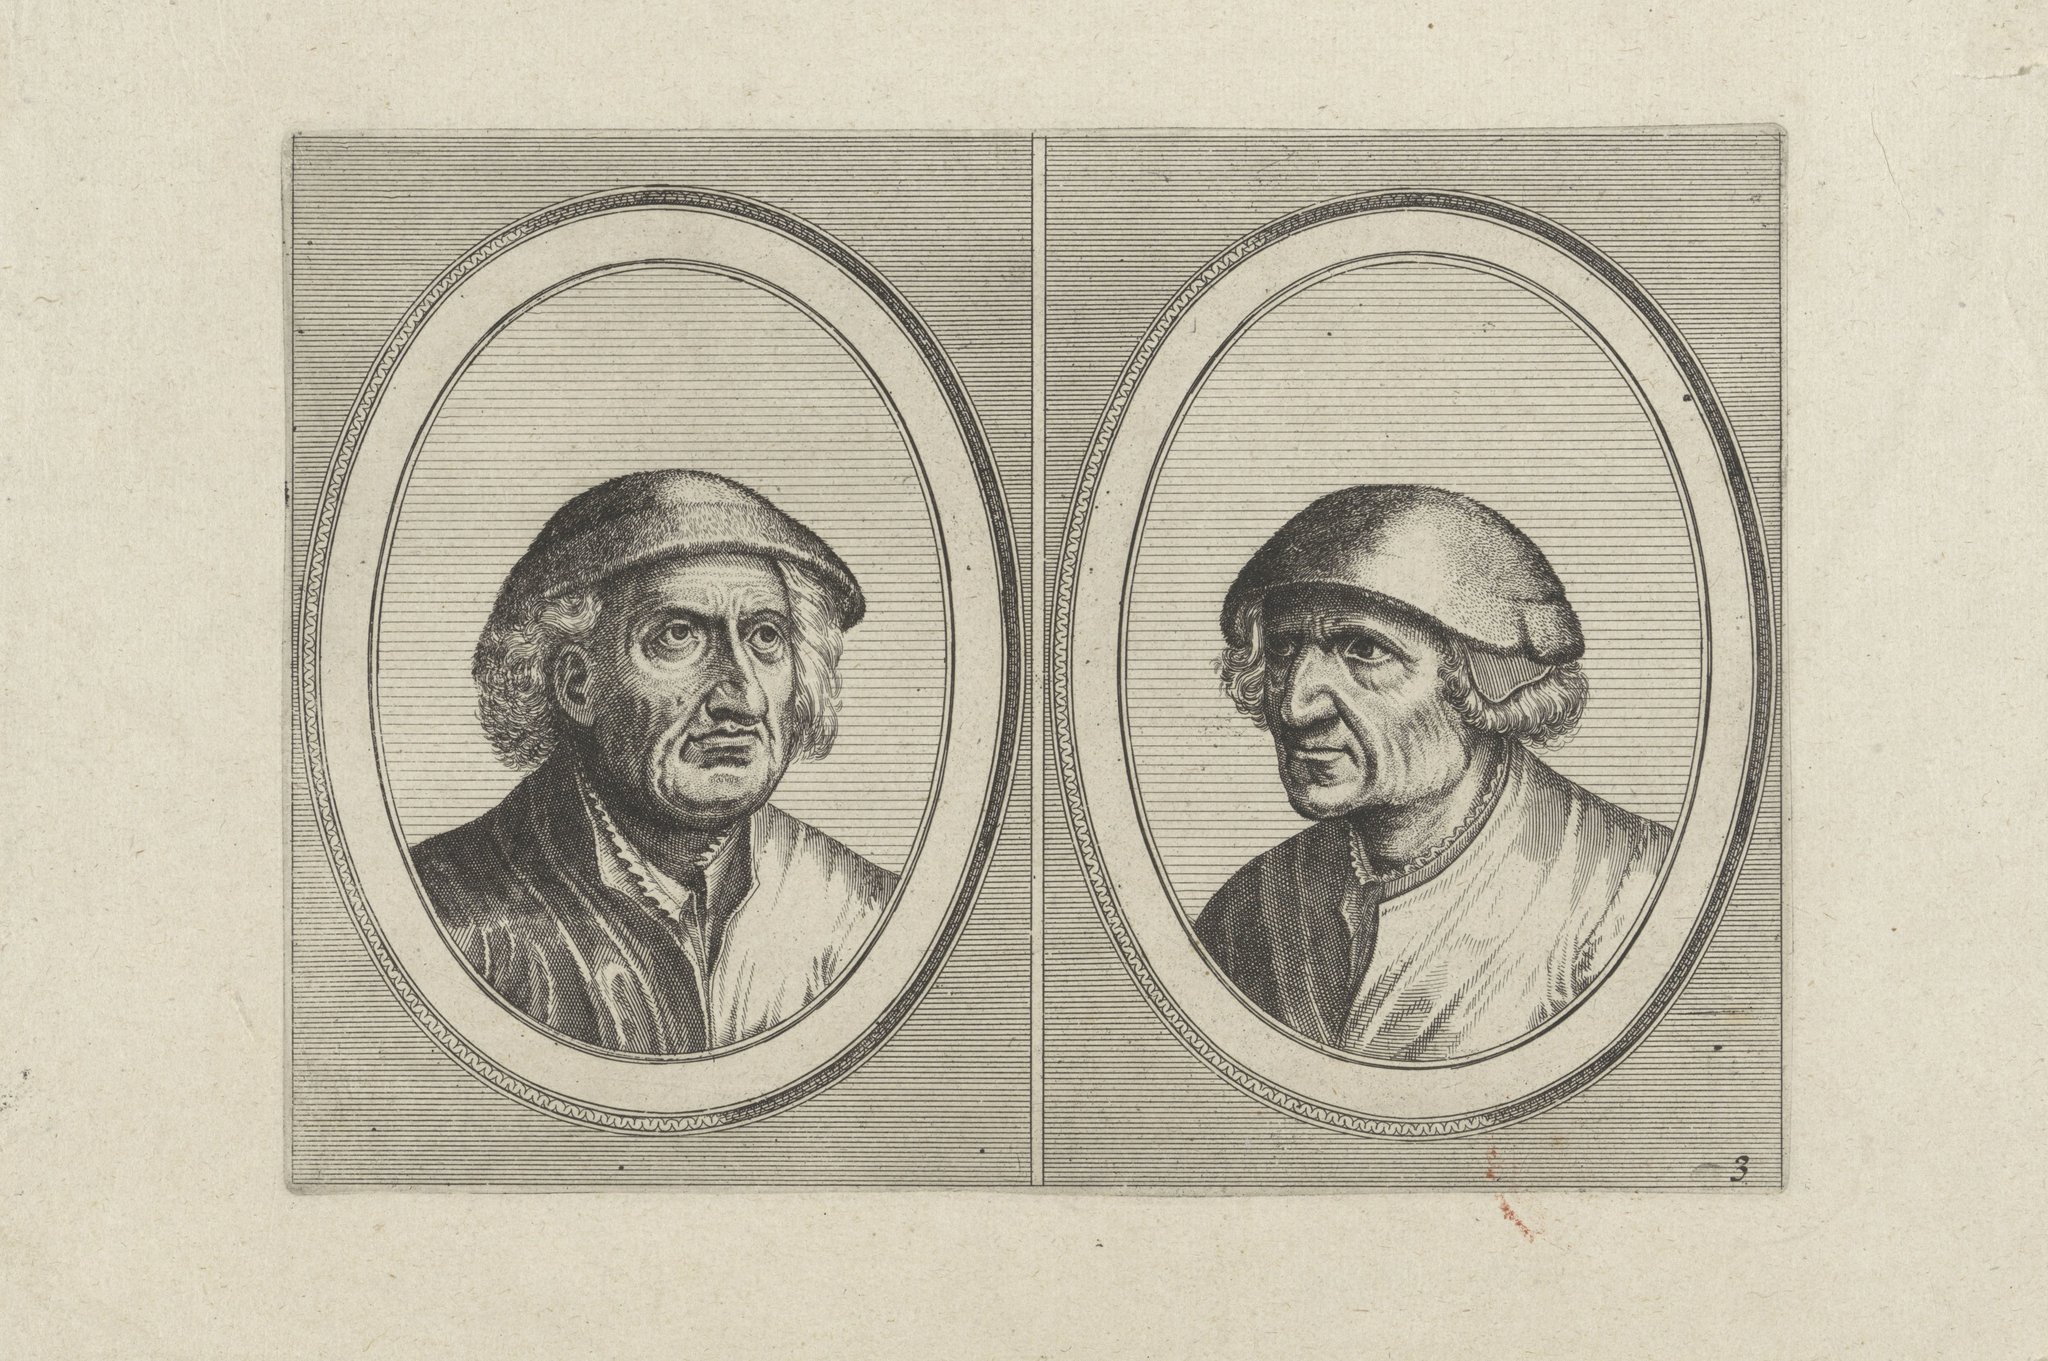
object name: print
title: Boerenkoppen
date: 1612-1652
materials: paper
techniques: engraving, etching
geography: amsterdam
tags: head-gear, farmers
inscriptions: collector's mark: Lugt 700, collector's mark: Lugt 240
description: Prent uit een serie van 36 prenten met koppen van boeren en boerinnen.